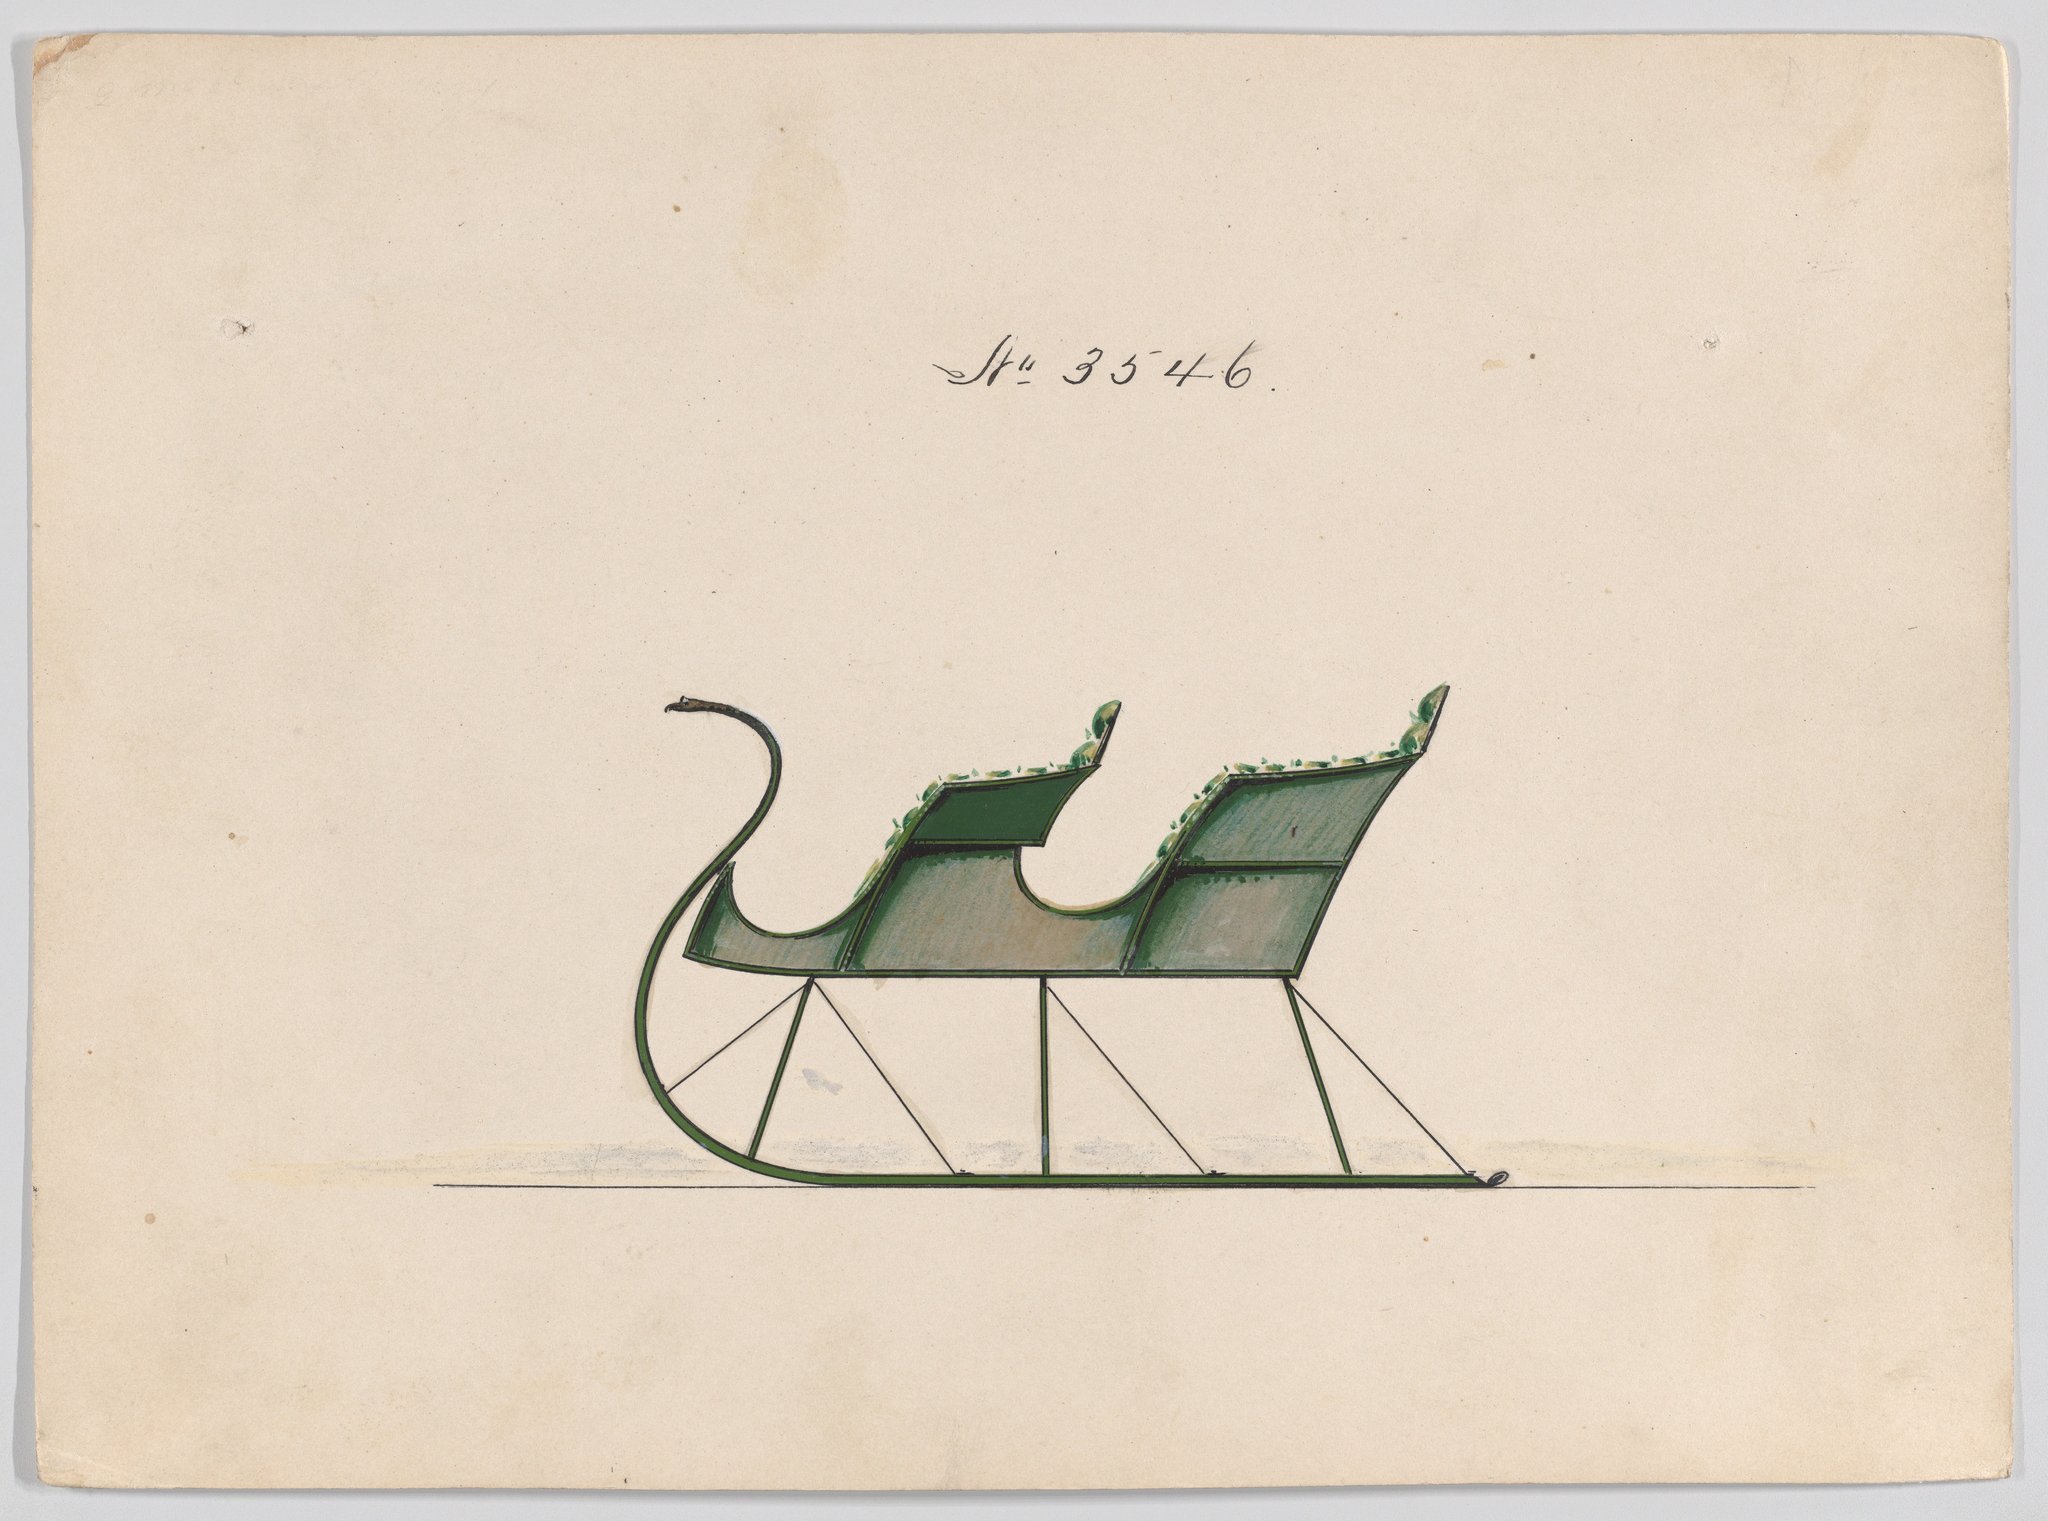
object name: drawing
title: Design for 2 Seat Sleigh, no. 3546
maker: brewster & co.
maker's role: manufacturer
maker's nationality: american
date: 1879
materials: gouache, gum arabic, ink, watercolor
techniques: pen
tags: sleighs